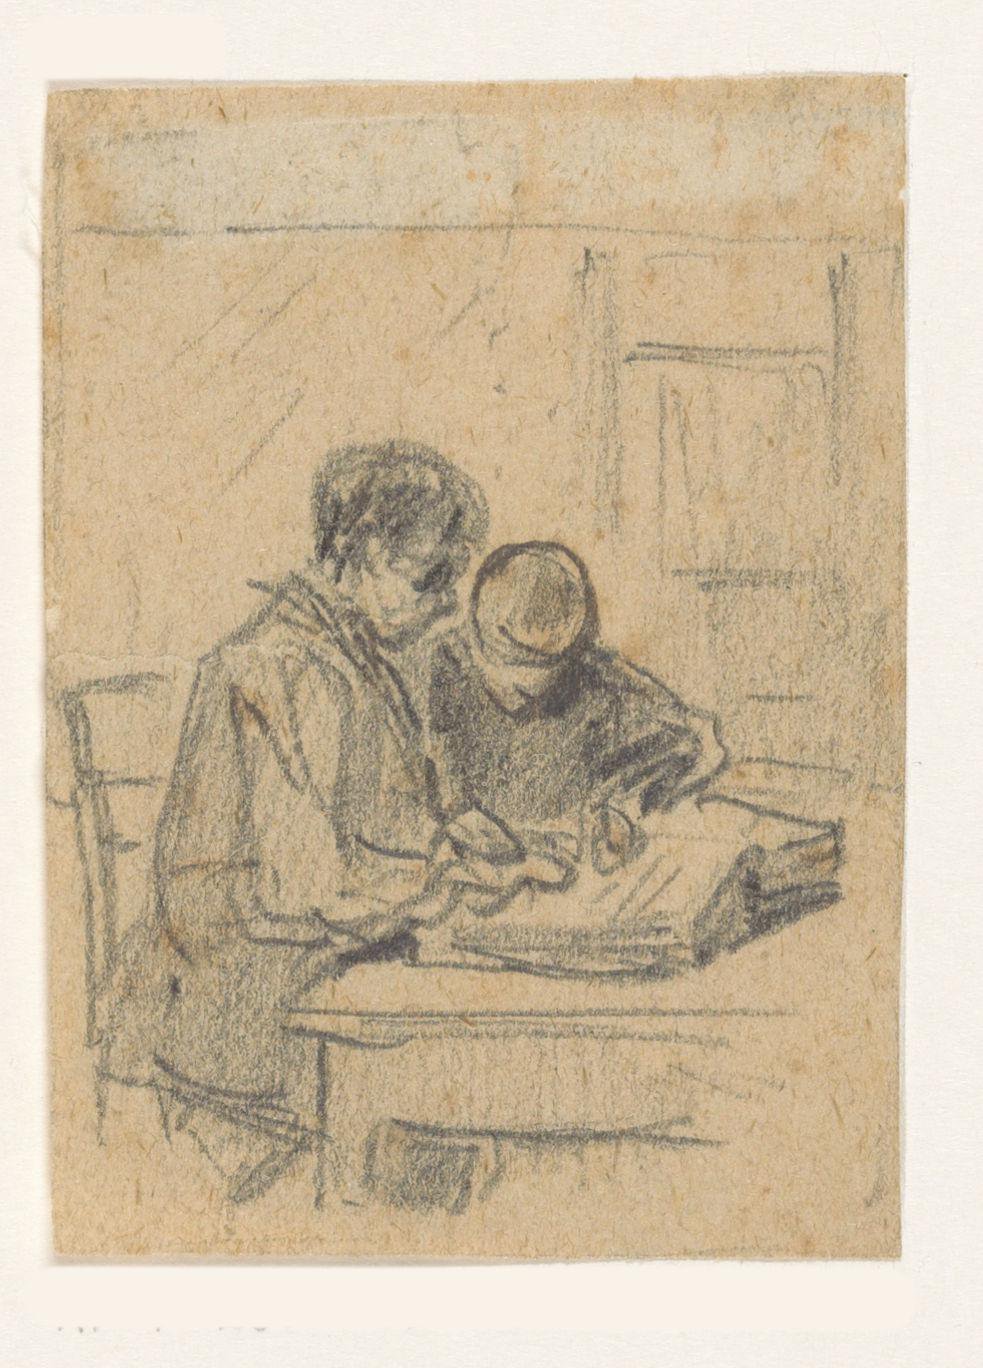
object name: drawing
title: Twee lezende figuren aan een tafel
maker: Anonymous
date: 1850-1925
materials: paper, pencil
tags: newspaper, news-sheet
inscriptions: collector's mark: Lugt 2228